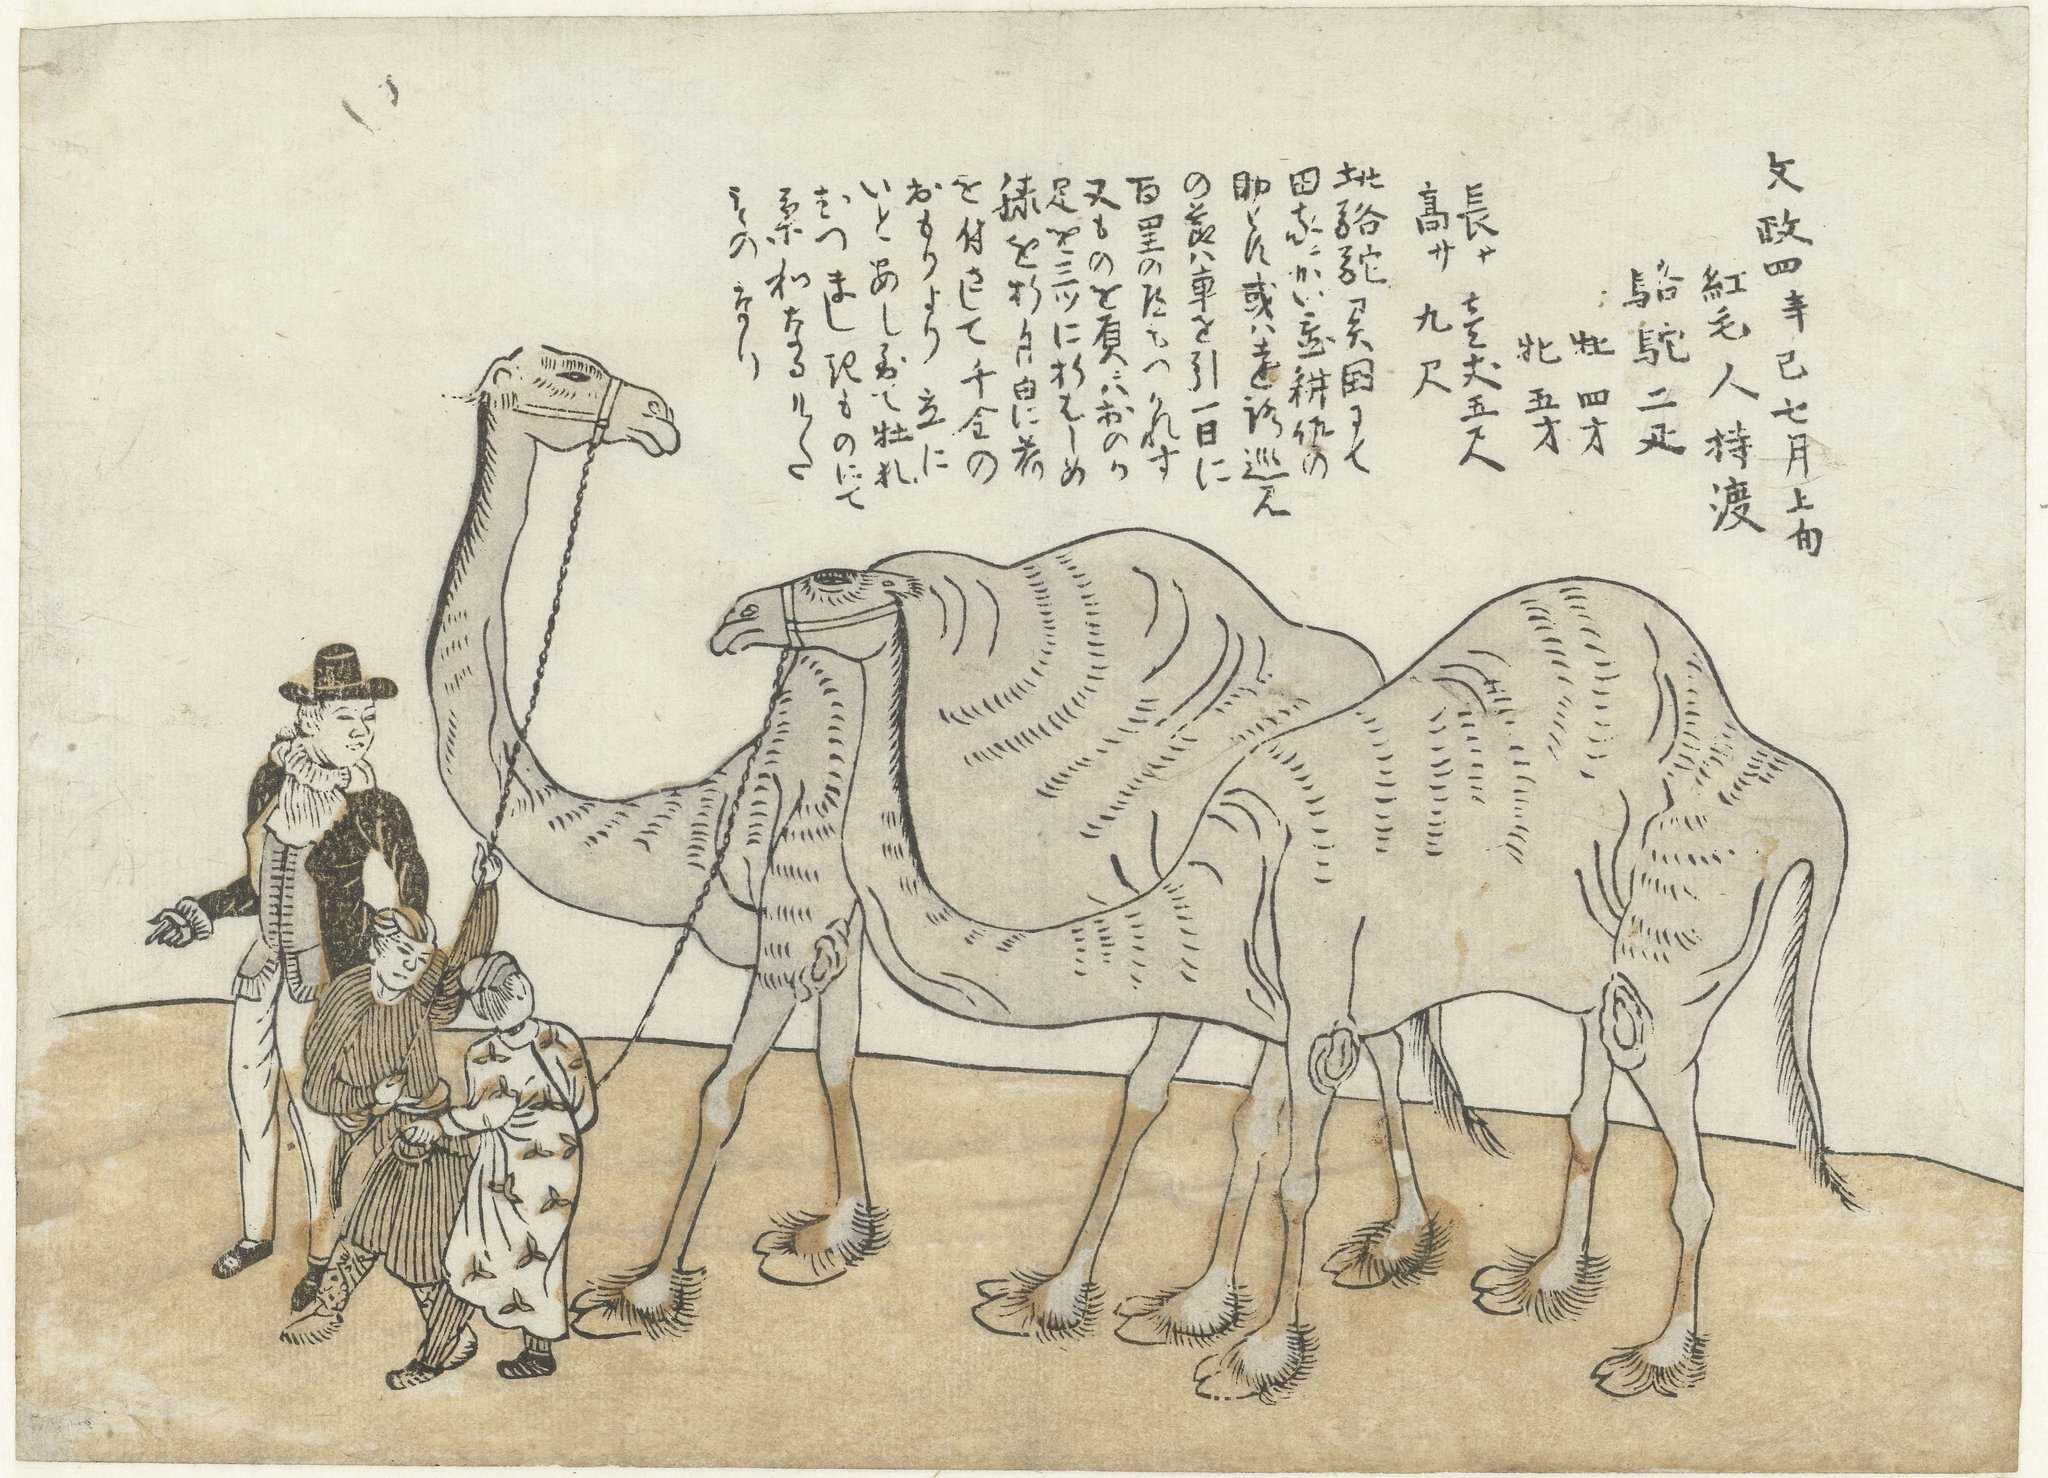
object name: print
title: Camel and Dromedary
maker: Anonymous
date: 1821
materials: paper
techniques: woodcut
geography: nagasaki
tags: hoofed animals: camel, adult man (+ three persons), hoofed animals: dromedary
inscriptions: collector's mark: Lugt 2228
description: The Dutch brought two camels to Japan in 1821, a male and a female. The animals were exhibited in many places in Japan and caused quite a stir. Prints like these served as mementos and provide some information about the creatures, such as their weight and dimensions.